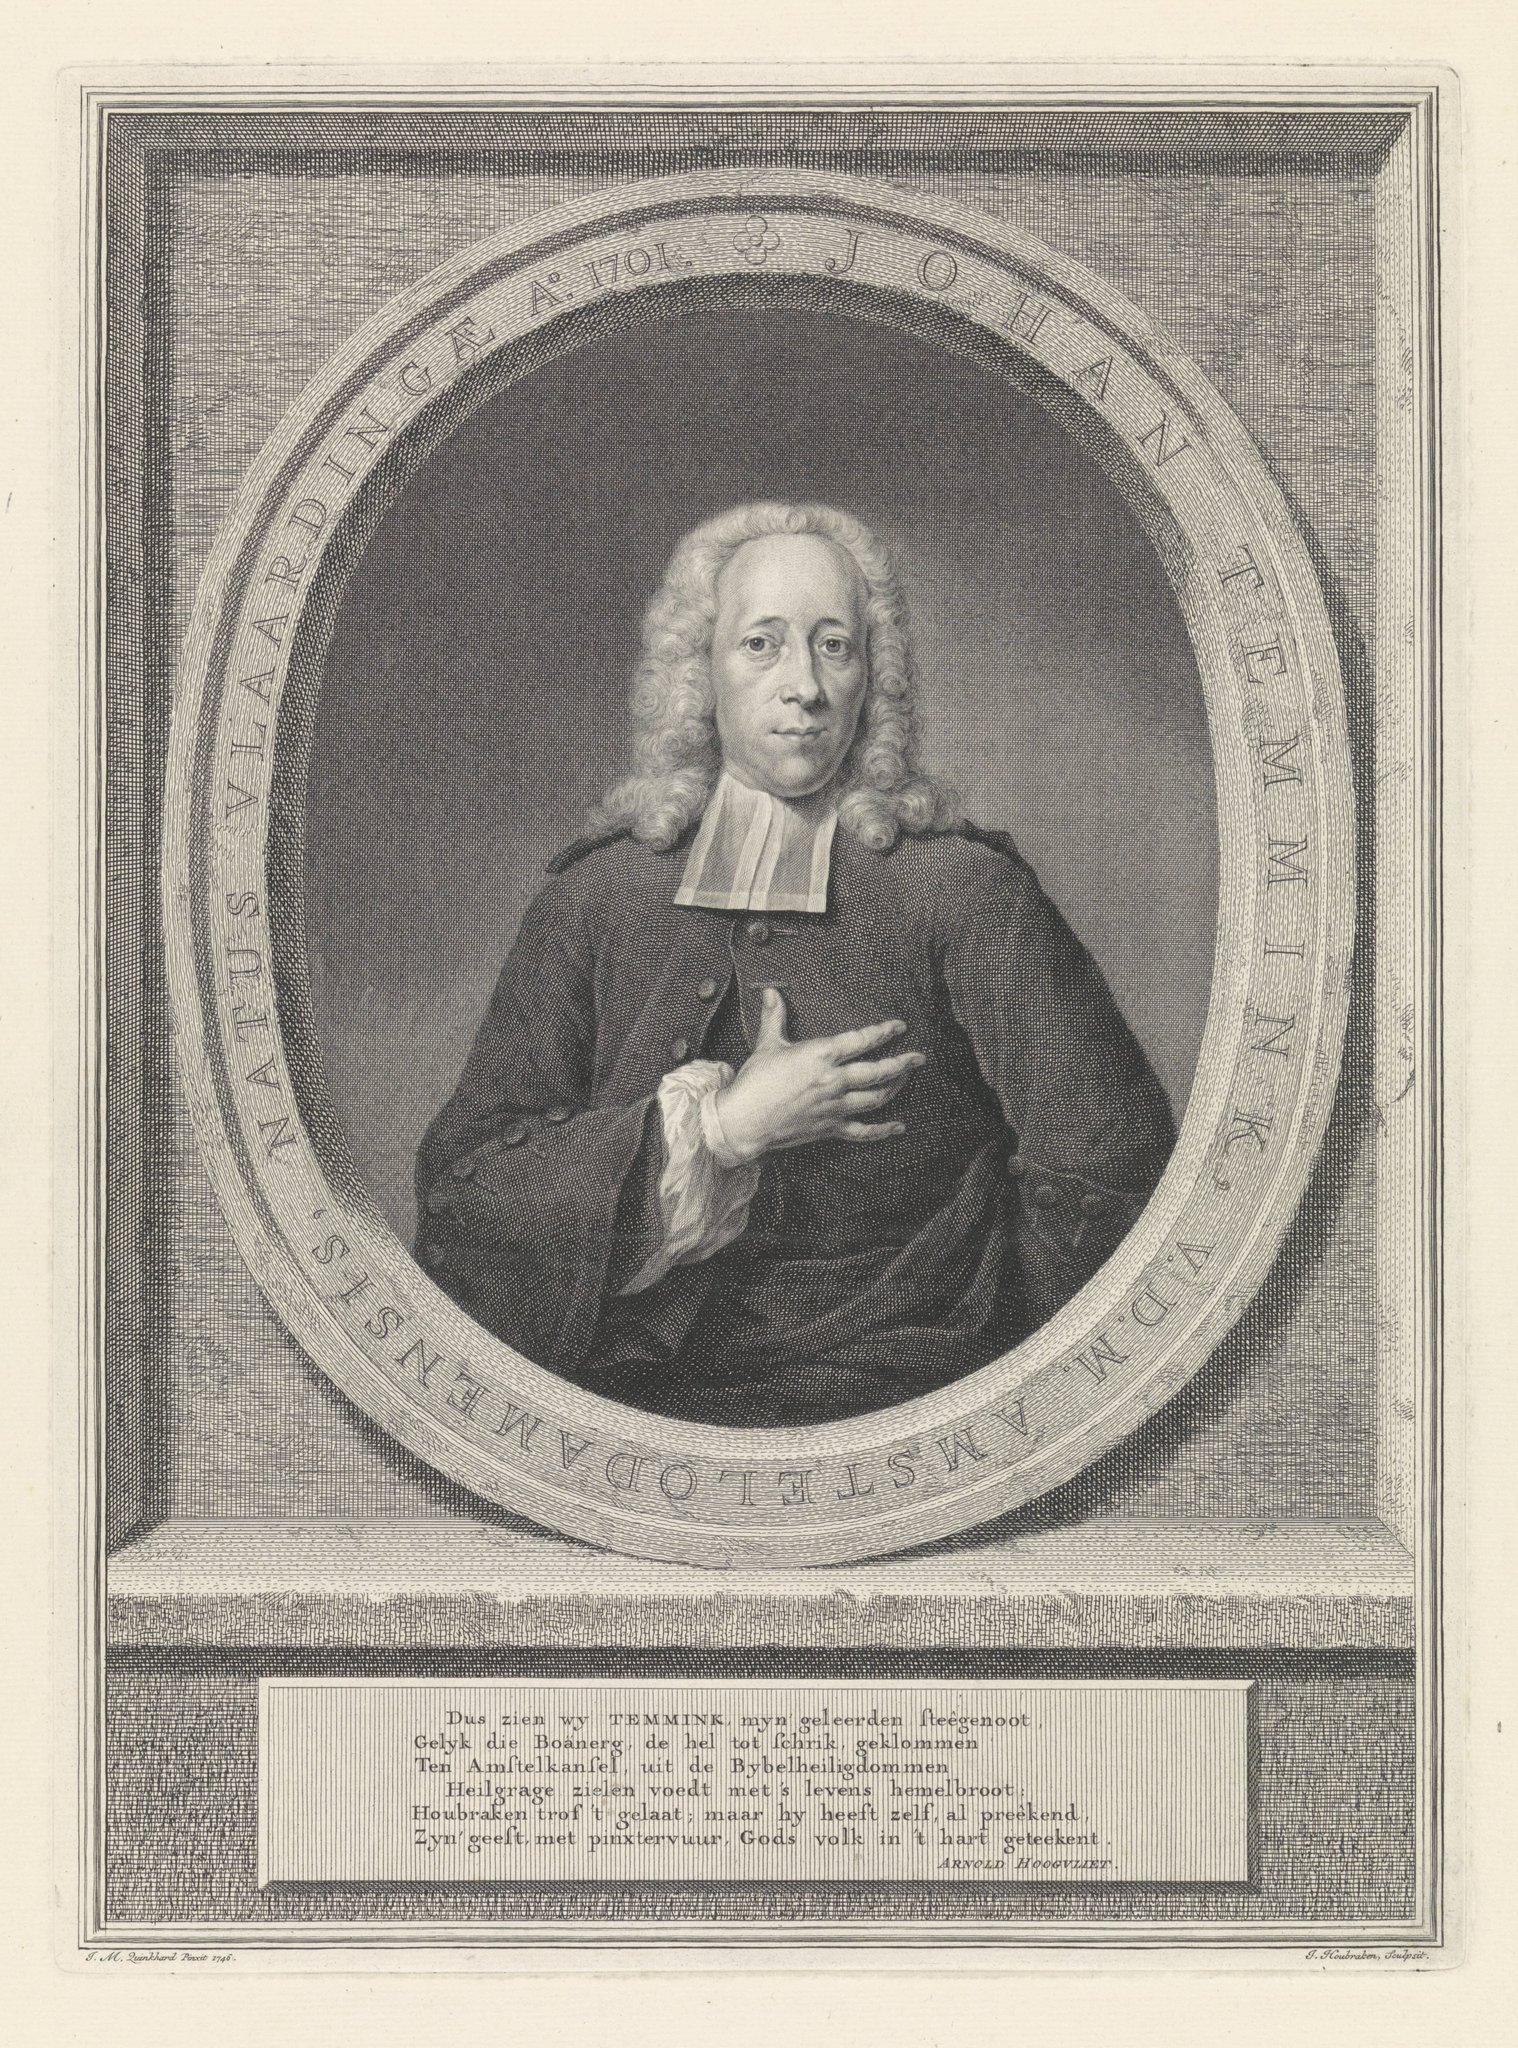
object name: print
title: Portret van Johan Temmink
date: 1746-1780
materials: paper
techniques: engraving, etching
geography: amsterdam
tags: historical persons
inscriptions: collector's mark: Lugt 240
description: Portret ten halven lijve van Johan Temmink in een architectonisch ovaal met randschrift in het Latijn. Het portret staat in een nis, met onder de onderste plint een zesregelig vers in het Nederlands.